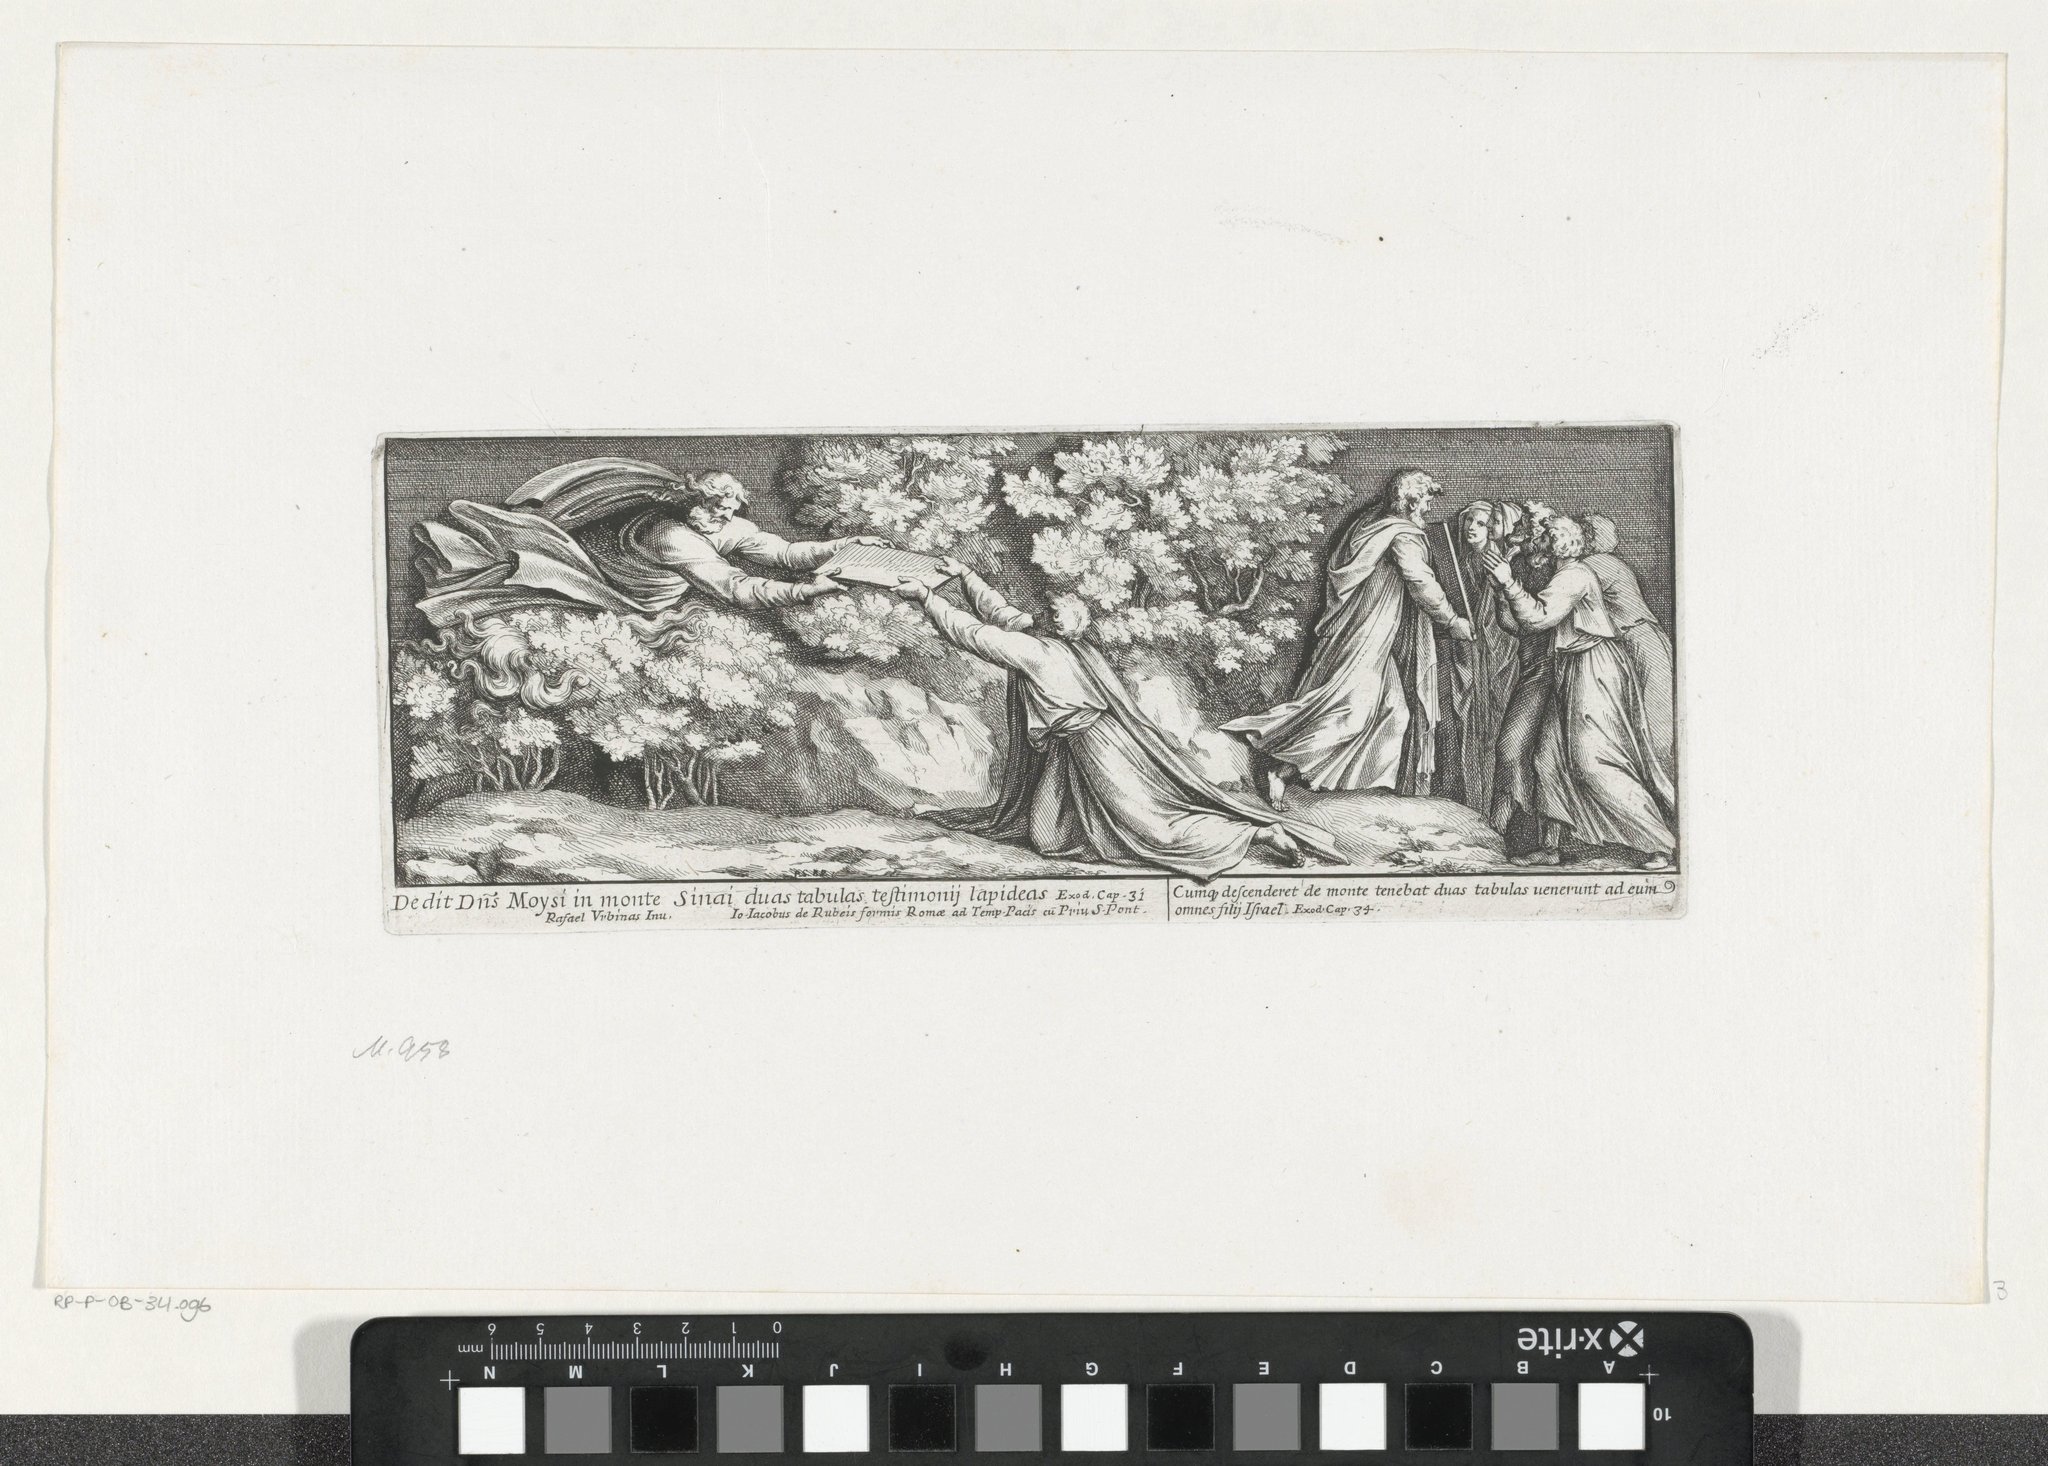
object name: print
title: Mozes ontvangt de tafelen der wet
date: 1645-1700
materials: paper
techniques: engraving, etching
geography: italy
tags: moses on mount sinai with the tables of the law (exodus 24:9-18, 31:18)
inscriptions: collector's mark: Lugt 2228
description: Prent uit een reeks van 14 prenten (+ titelprent) naar schilderingen door Rafaël in de Stanze di Raffaello in het Apostolisch Paleis in het Vaticaan en naar ontwerpen voor wandtapijten voor de Sixtijnse Kapel door Rafaël. Naar een schildering door Rafaël in de Stanza di Eliodoro.